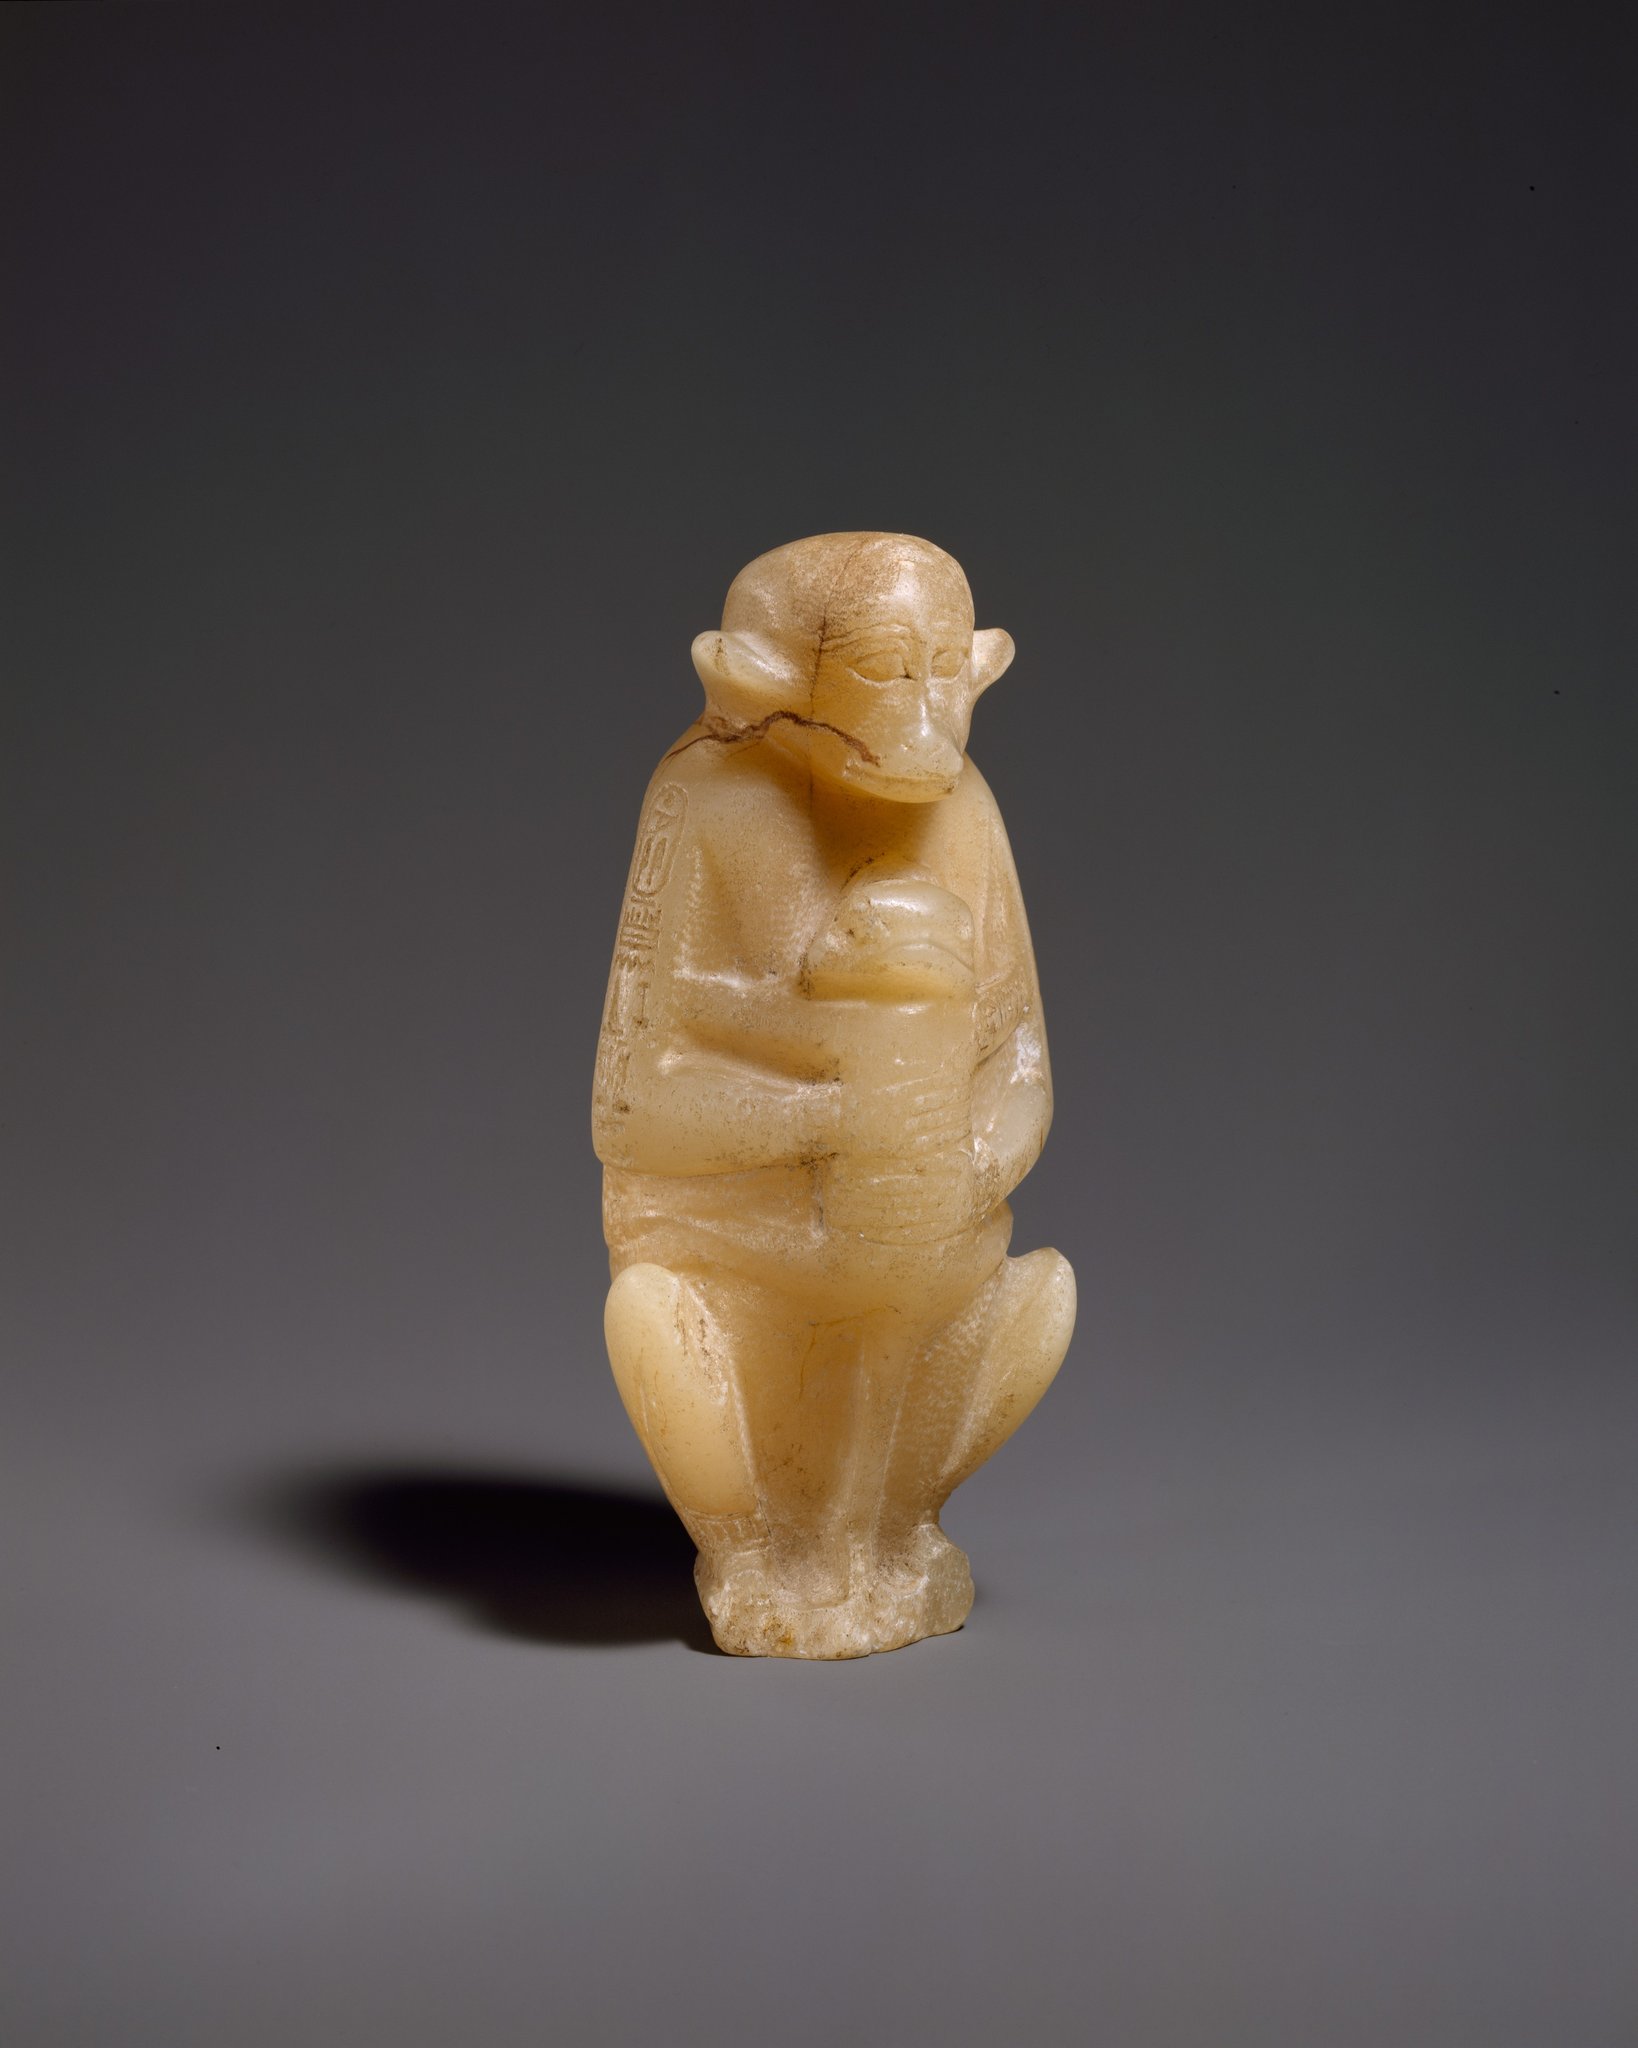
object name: vase, monkey, baby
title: Vase in the Shape of a Mother Monkey with Her Offspring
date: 2289-2255 BCE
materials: paint, stone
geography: egypt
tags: hieroglyphs,monkeys